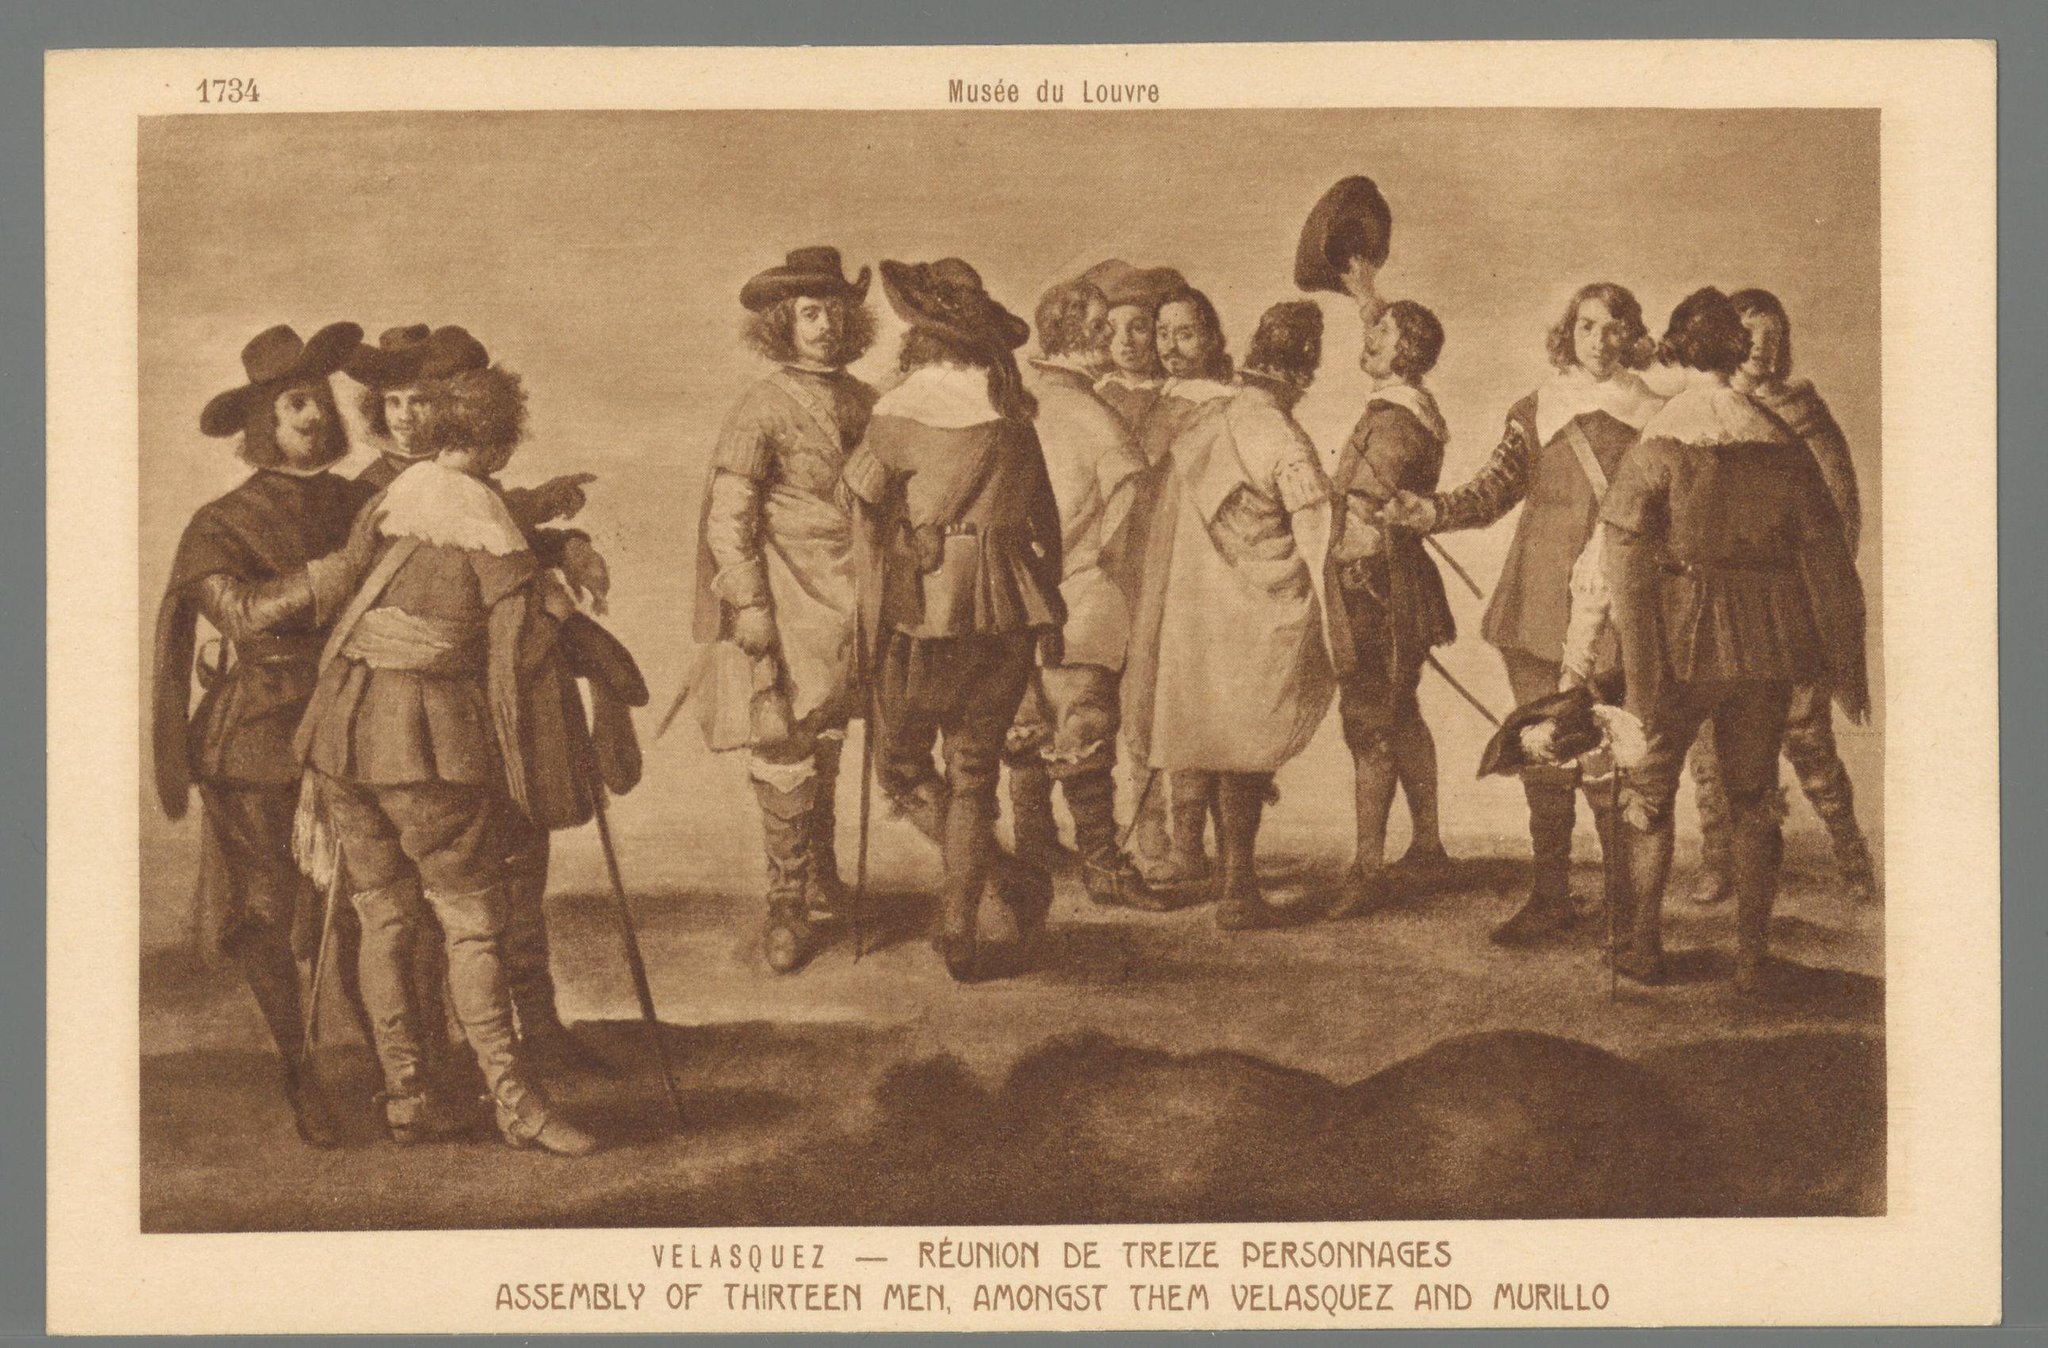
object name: ansichtkaart, prentbriefkaart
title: Musée du Louvre. Velasquez - Réunion de treize personnages / Assembly of thirteen men, amongst them Velasquez and Murillo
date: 1903-1930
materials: cardboard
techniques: rotogravure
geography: paris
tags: sevilla, painter, draughtsman, bartolomé esteban murillo, diego rodriguez de silva y velázquez, permanent exhibition, museum, picture, painting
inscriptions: collector's mark: ‘AFE v S’